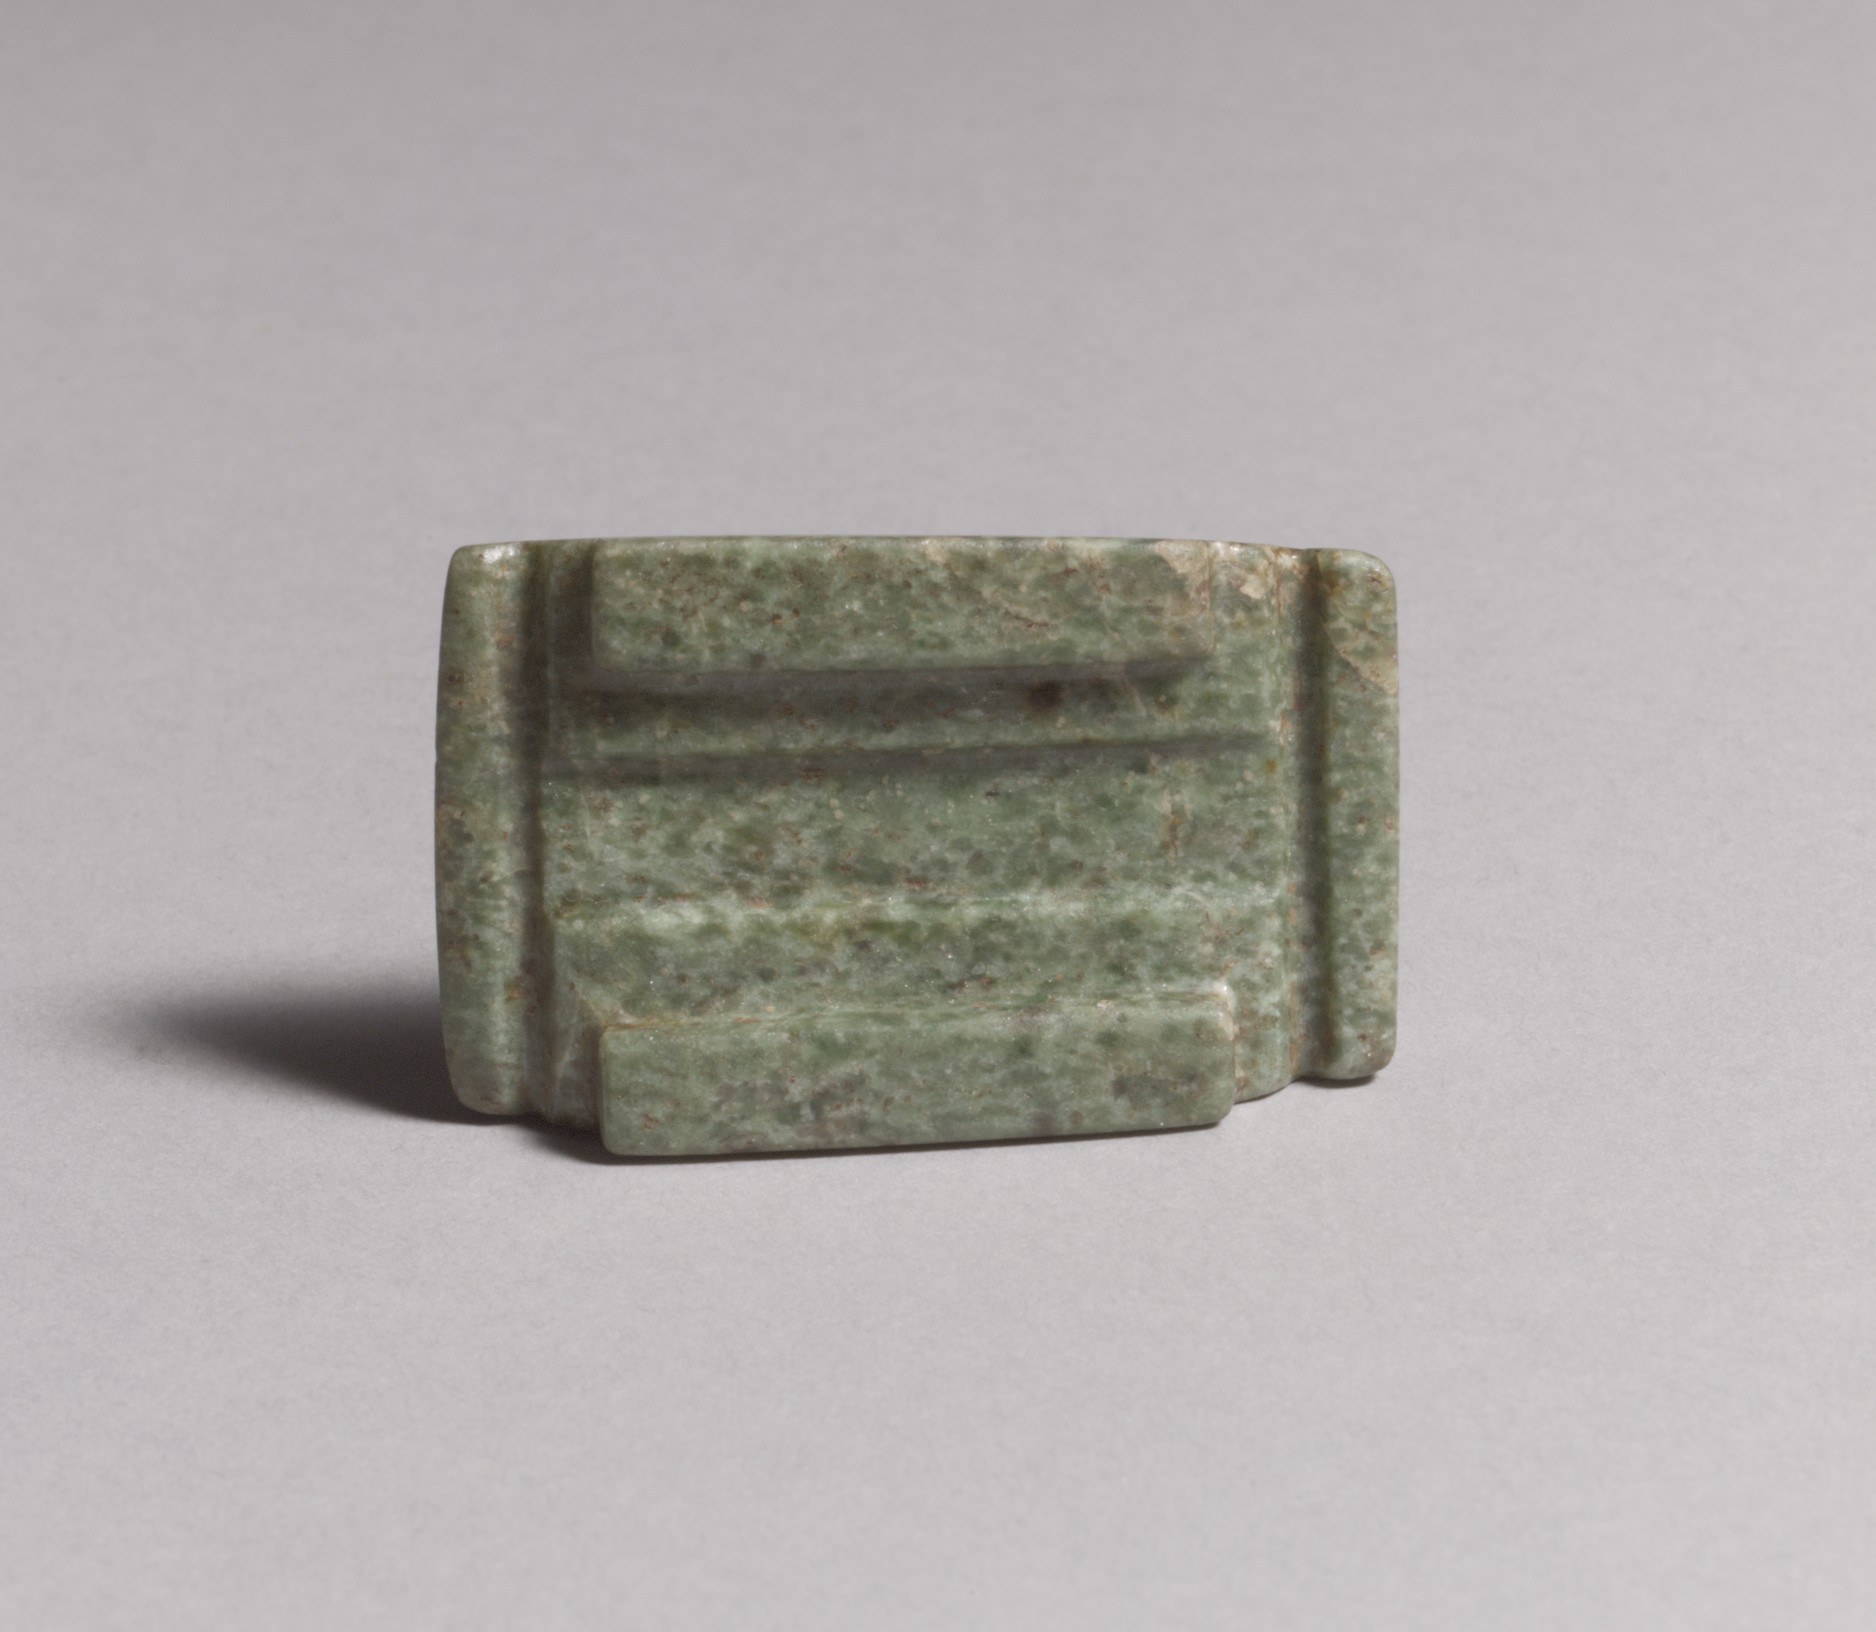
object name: ornament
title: Miniature Ballcourt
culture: mexican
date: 1501-1600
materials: stone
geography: mexico